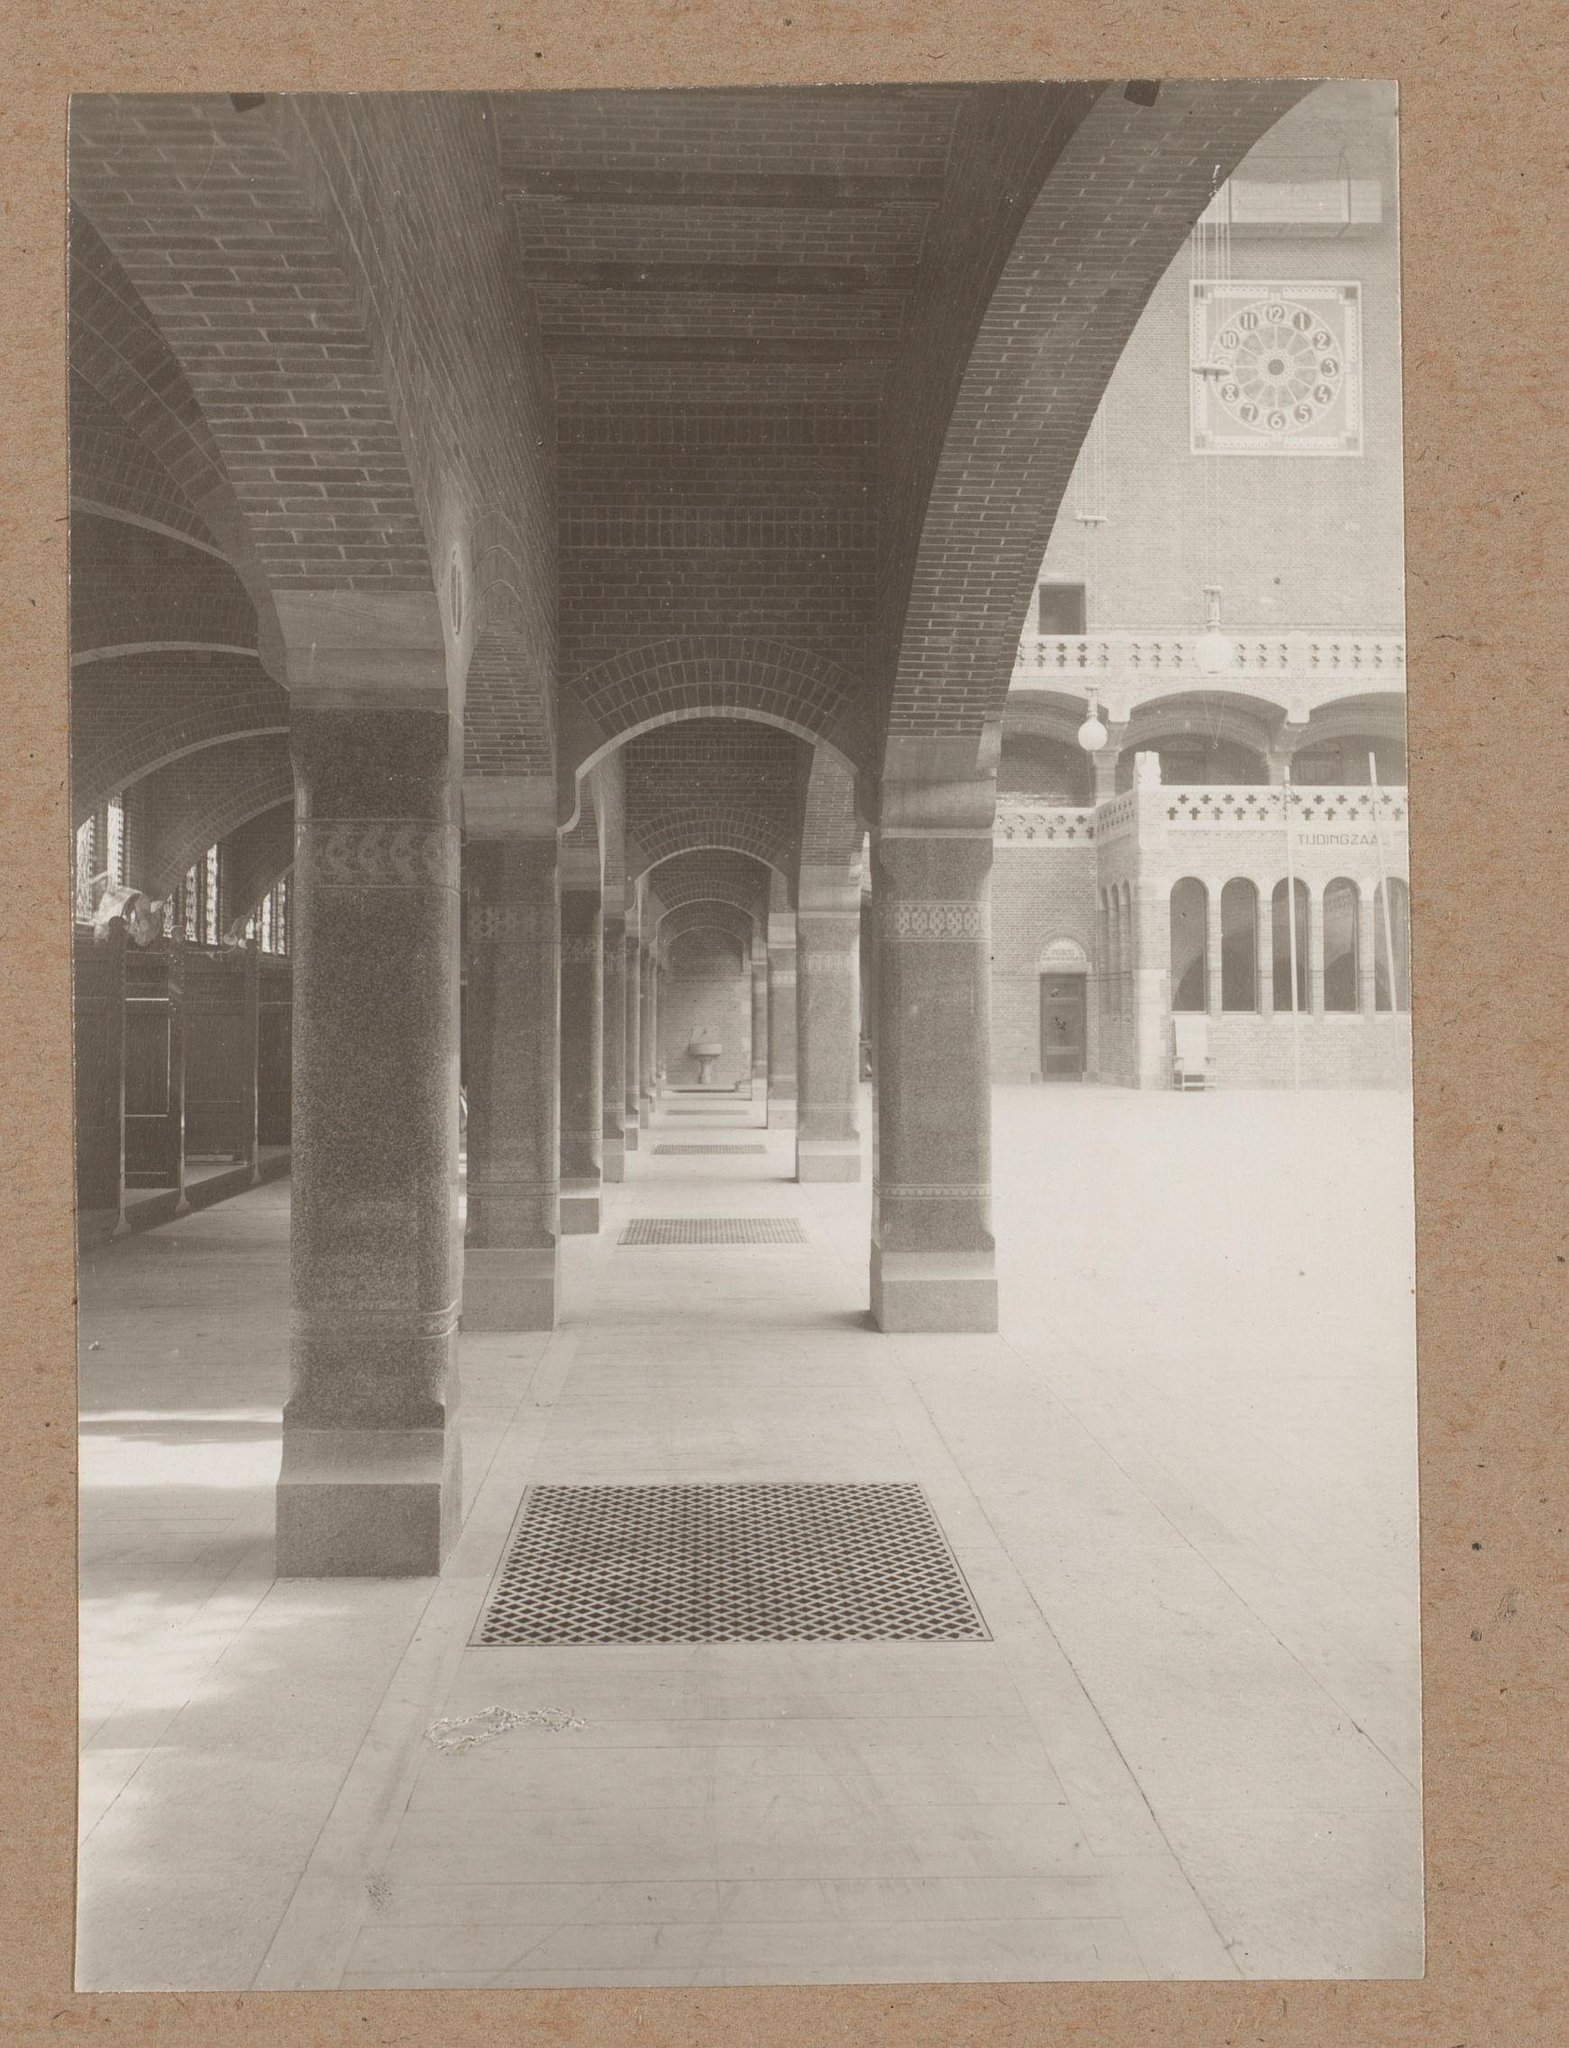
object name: photograph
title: Zuilengalerij in de Goederenbeurszaal in de Beurs van Berlage te Amsterdam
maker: Anonymous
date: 1903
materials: paper, cardboard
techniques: gelatin silver print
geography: amsterdam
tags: column, pillar ~ architecture, stock exchange, stock-market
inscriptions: number: ‘8 a b’